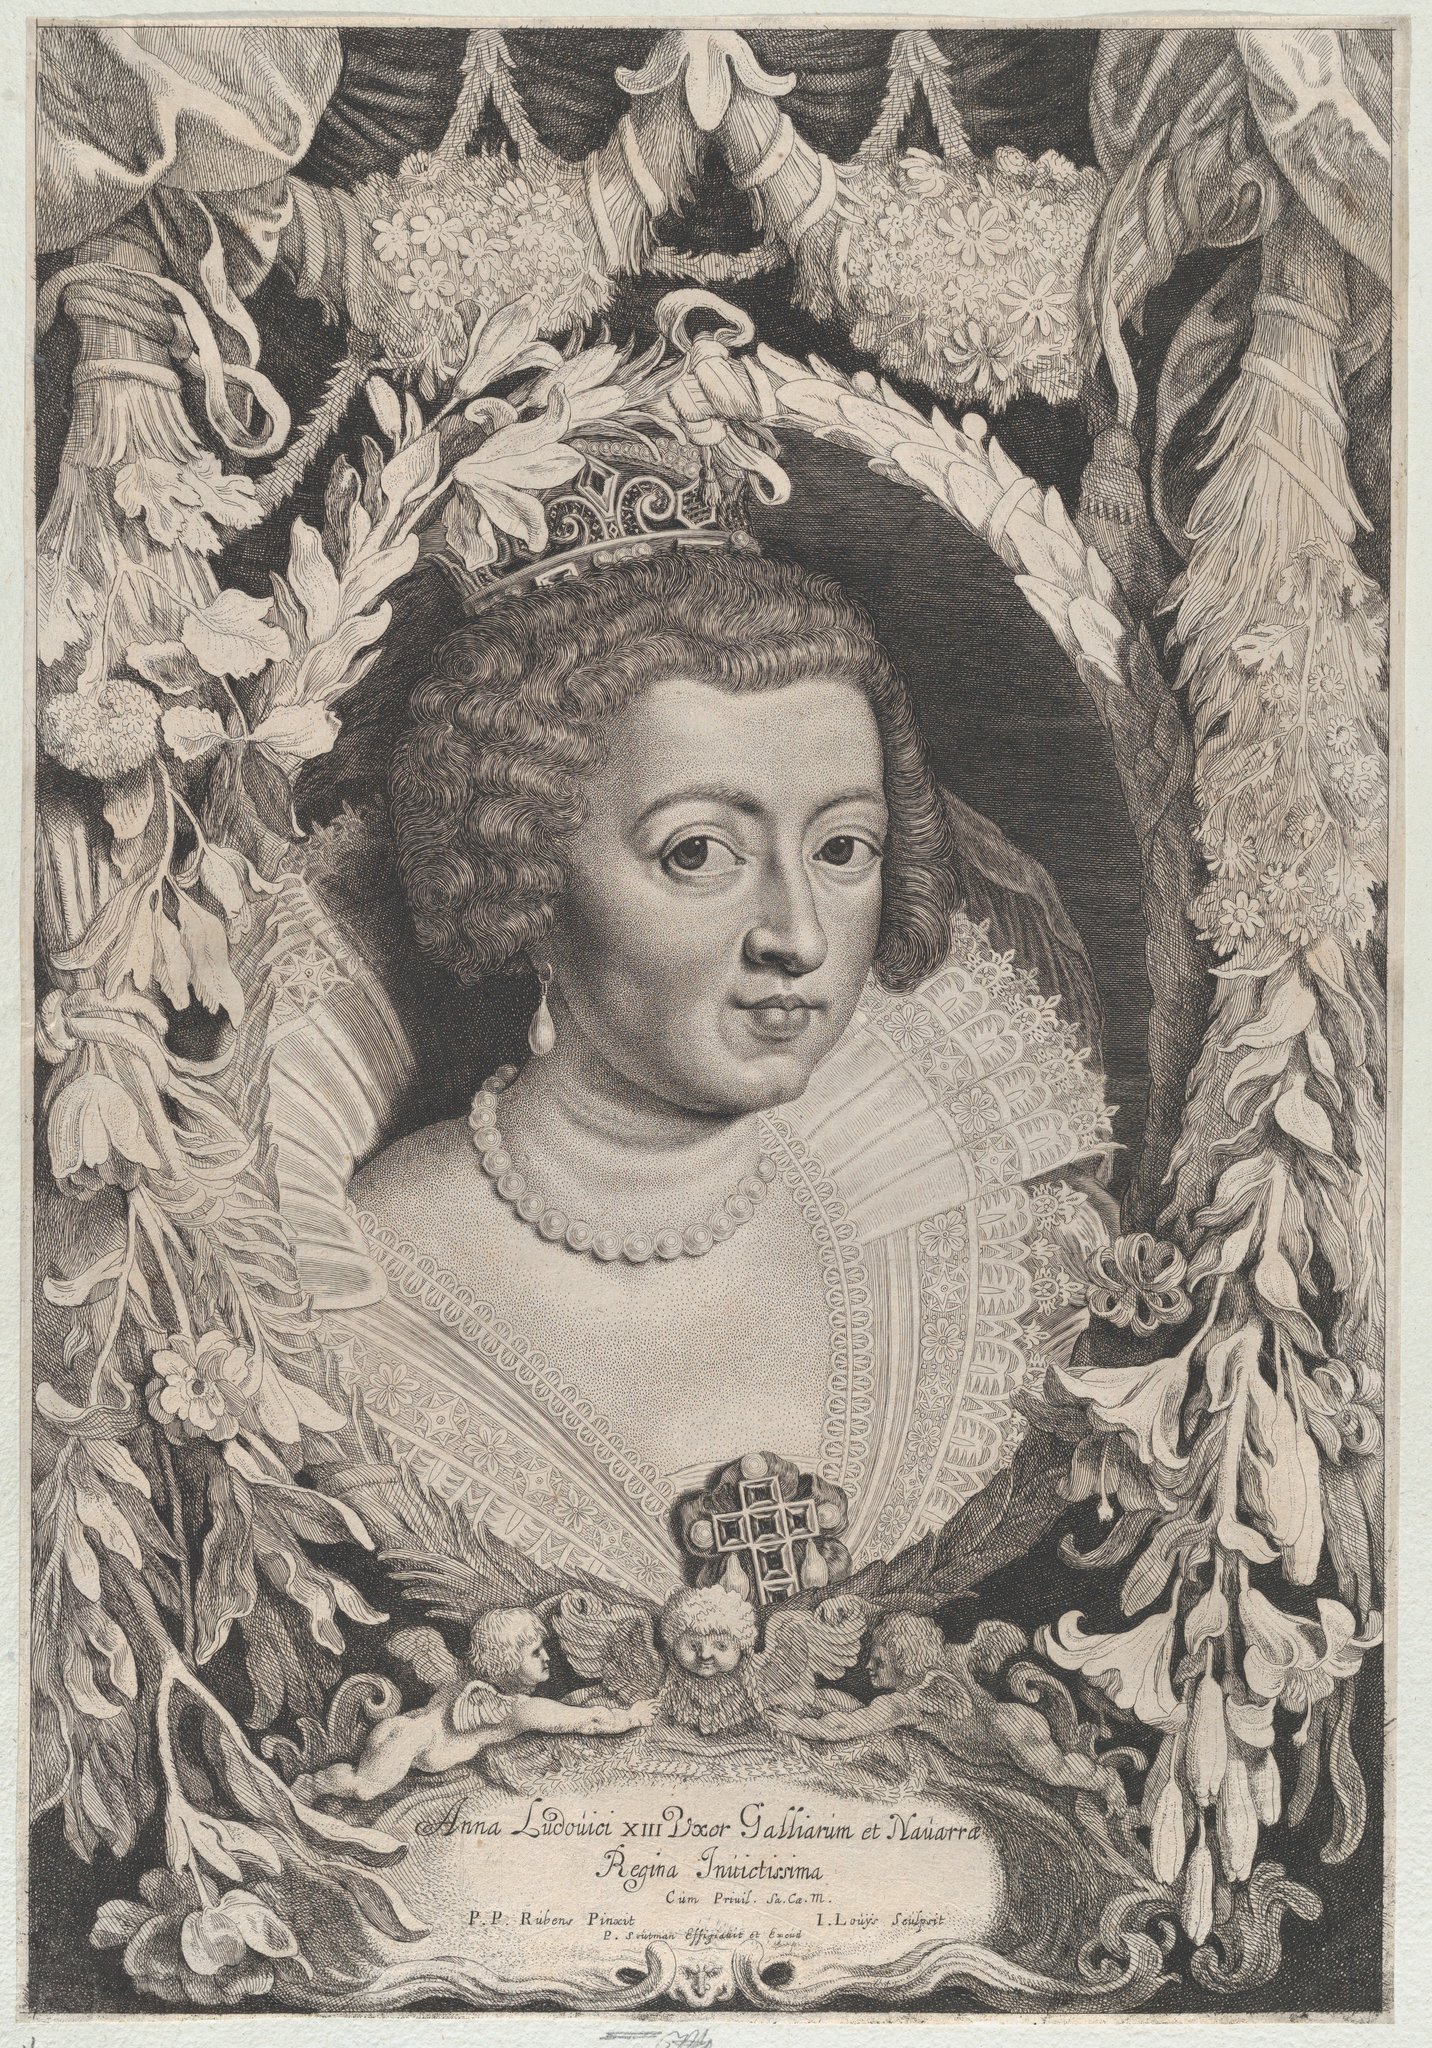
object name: print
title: Portrait of Anne of Austria, Queen of France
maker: jacob louys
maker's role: artist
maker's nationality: dutch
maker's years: 1595-1673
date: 1650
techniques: engraving, etching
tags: queens,portraits,women